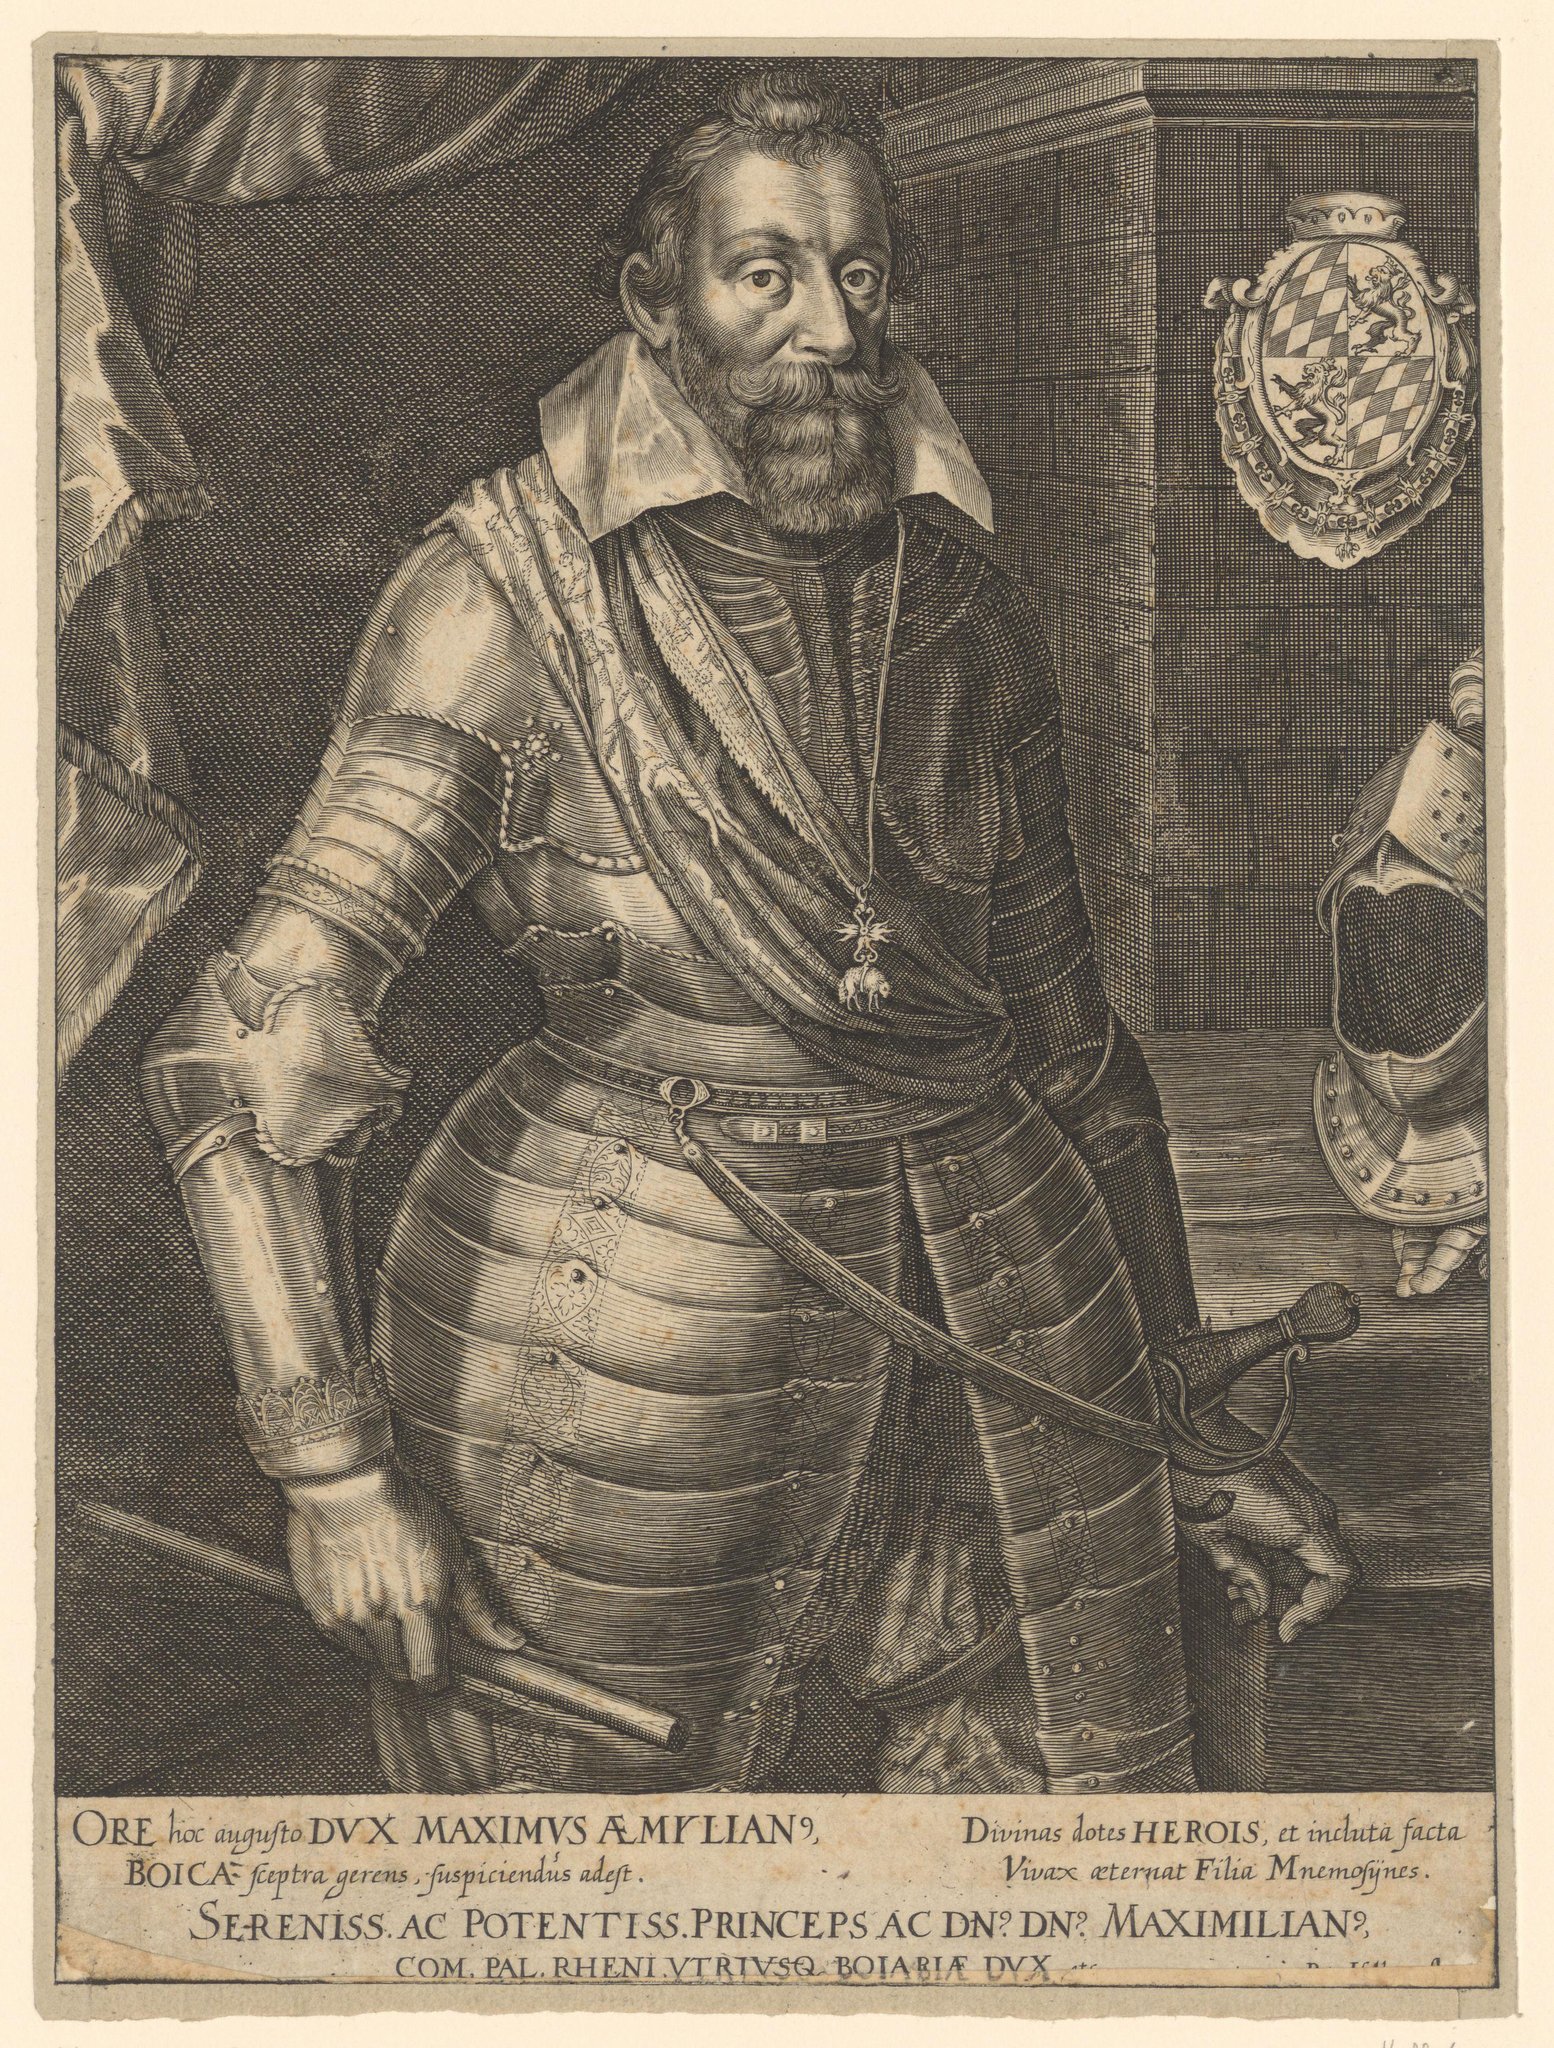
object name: print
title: Portret van Maximiliaan I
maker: peter isselburg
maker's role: print maker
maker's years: 1568-1630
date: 1583-1630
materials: paper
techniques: engraving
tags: maximiliaan i (keurvorst van beieren), armour, historical persons, knighthood order of the golden fleece - insignia of a knighthood order, e.g.: badge, chain (with name of order), baton of general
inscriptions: collector's mark: Lugt 2228